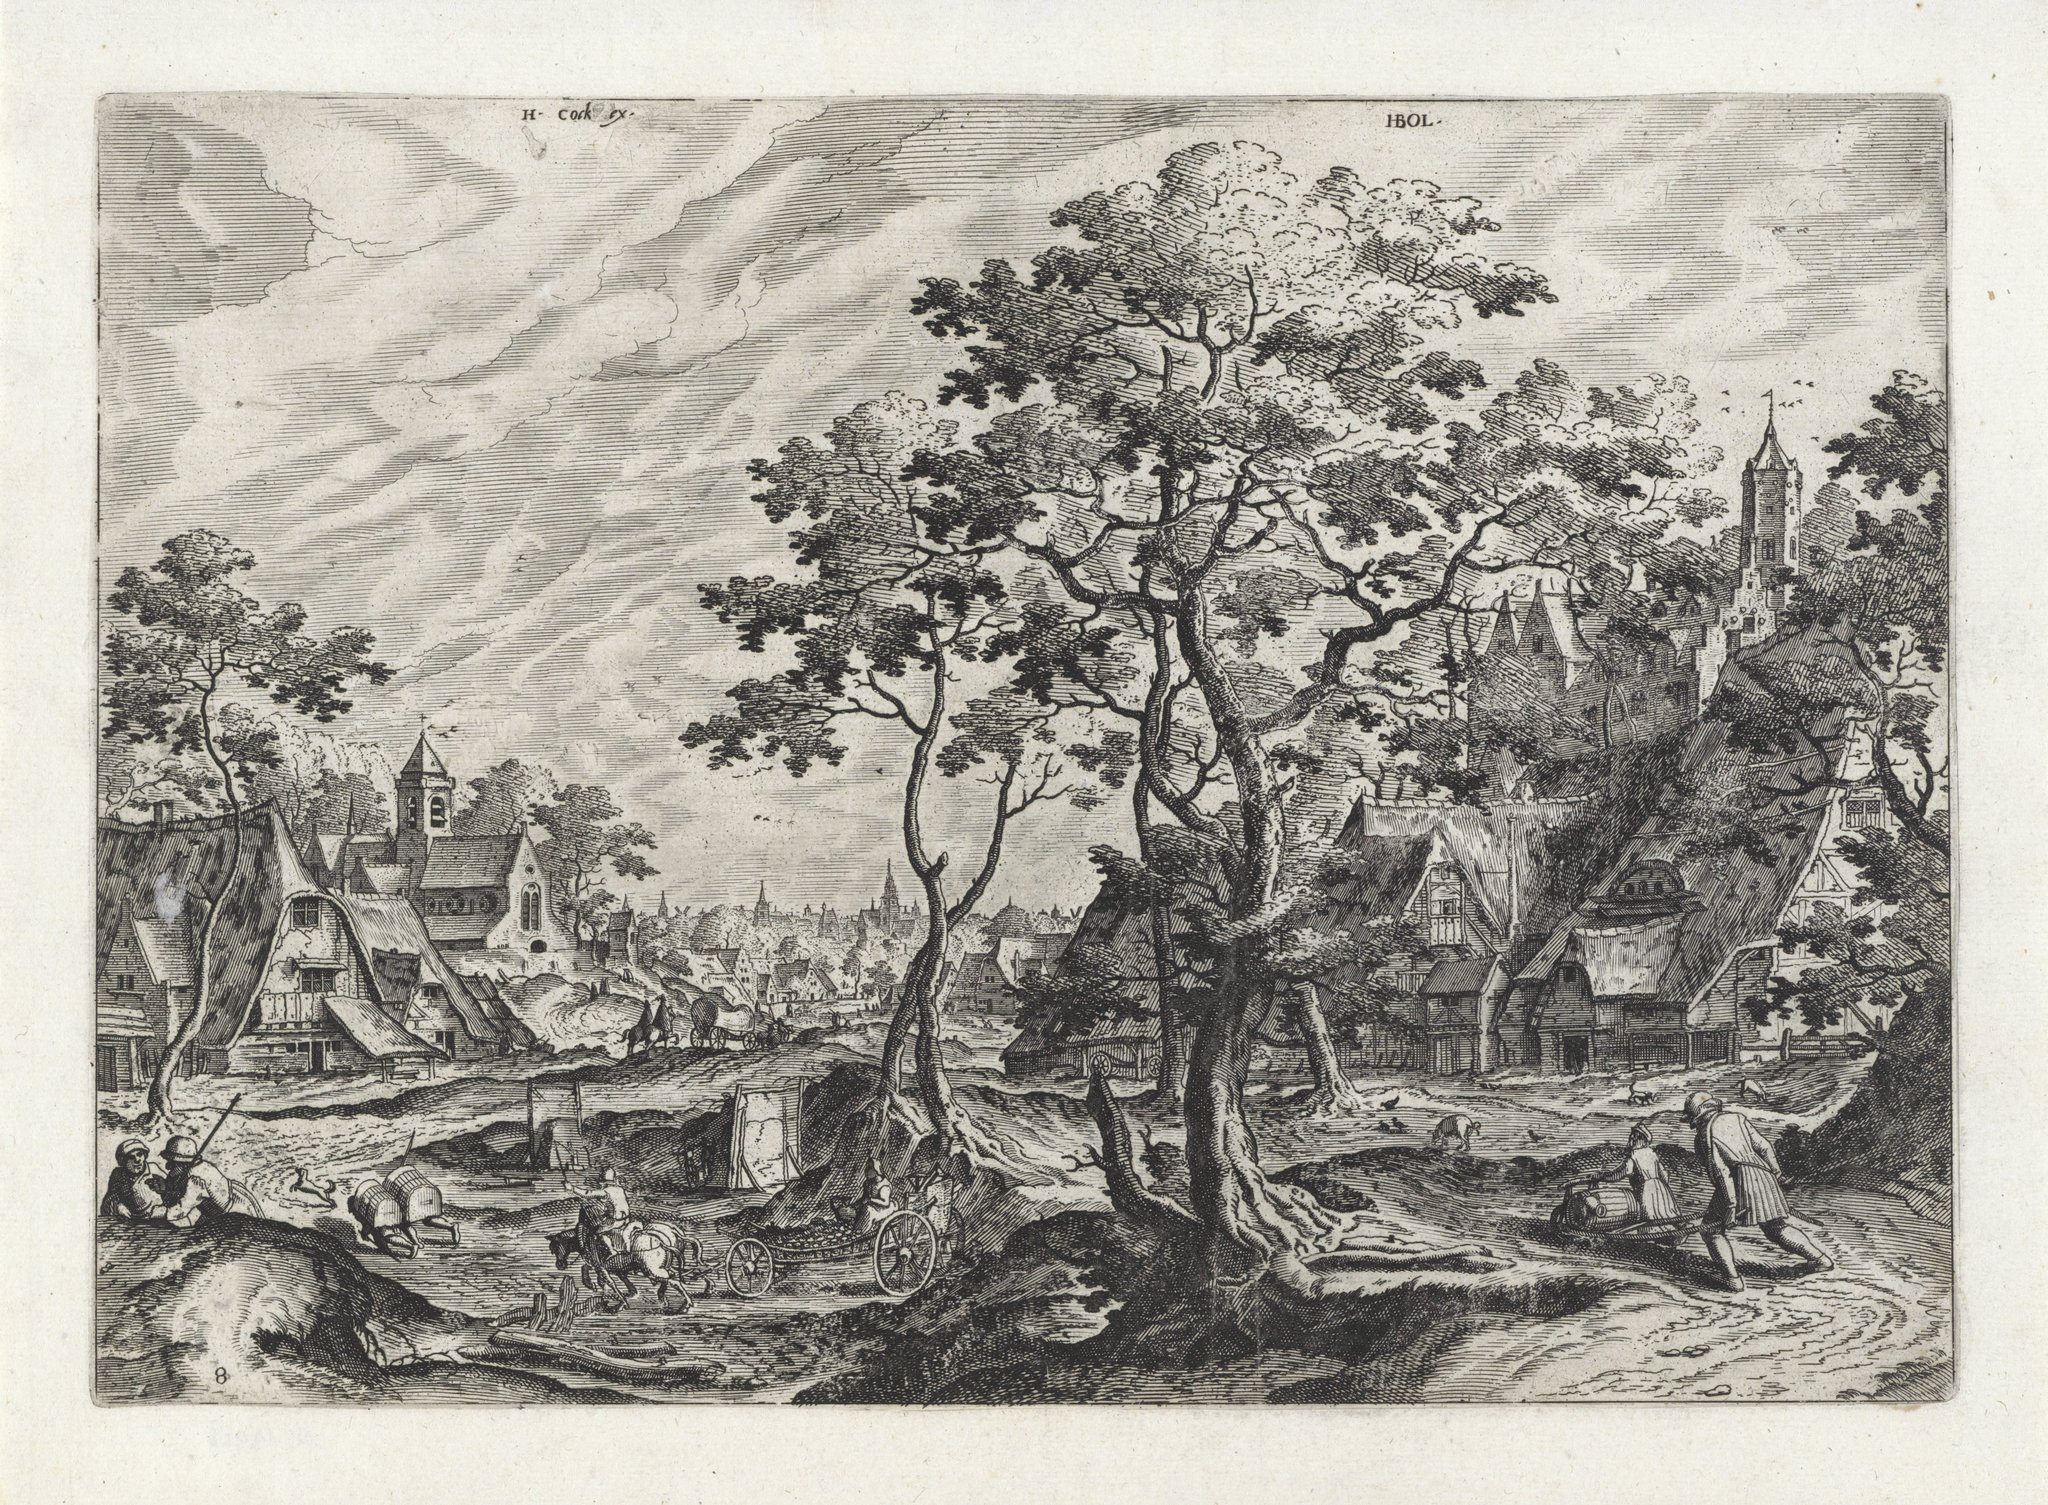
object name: print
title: Dorpsgezicht met reizende figuren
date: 1548-1570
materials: paper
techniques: etching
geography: antwerp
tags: pedlar, public road in village (+ city(-scape) with figures, staffage), (farm) wagon, freight wagon, cart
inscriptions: collector's mark: Lugt 240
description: Door een dorp loopt een weg met enkele bomen. Op de weg zijn enkele reizende figuren te zien. Vooraan twee marskramers, een vrouw op een paard-en-wagen en twee figuren die een ton vervoeren. Verderop twee ruiters en een gehuifde wagen.